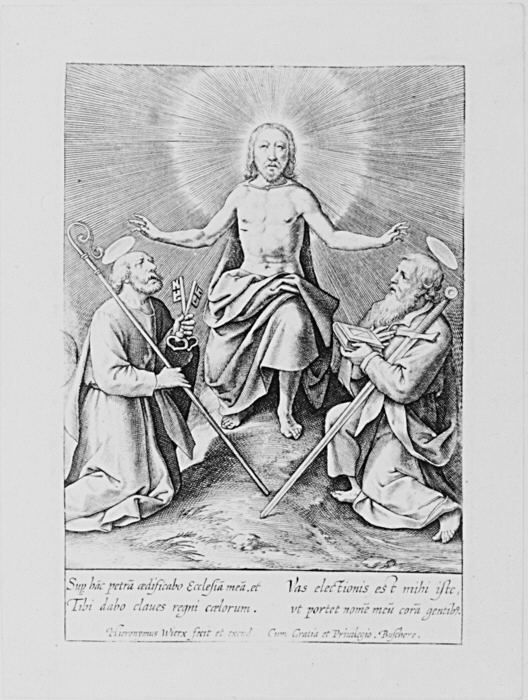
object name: print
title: Christ Between Saints Peter and Paul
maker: hieronymus wierix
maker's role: artist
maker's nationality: netherlandish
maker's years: 1553-1619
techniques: engraving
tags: christ,saint paul,saint peter